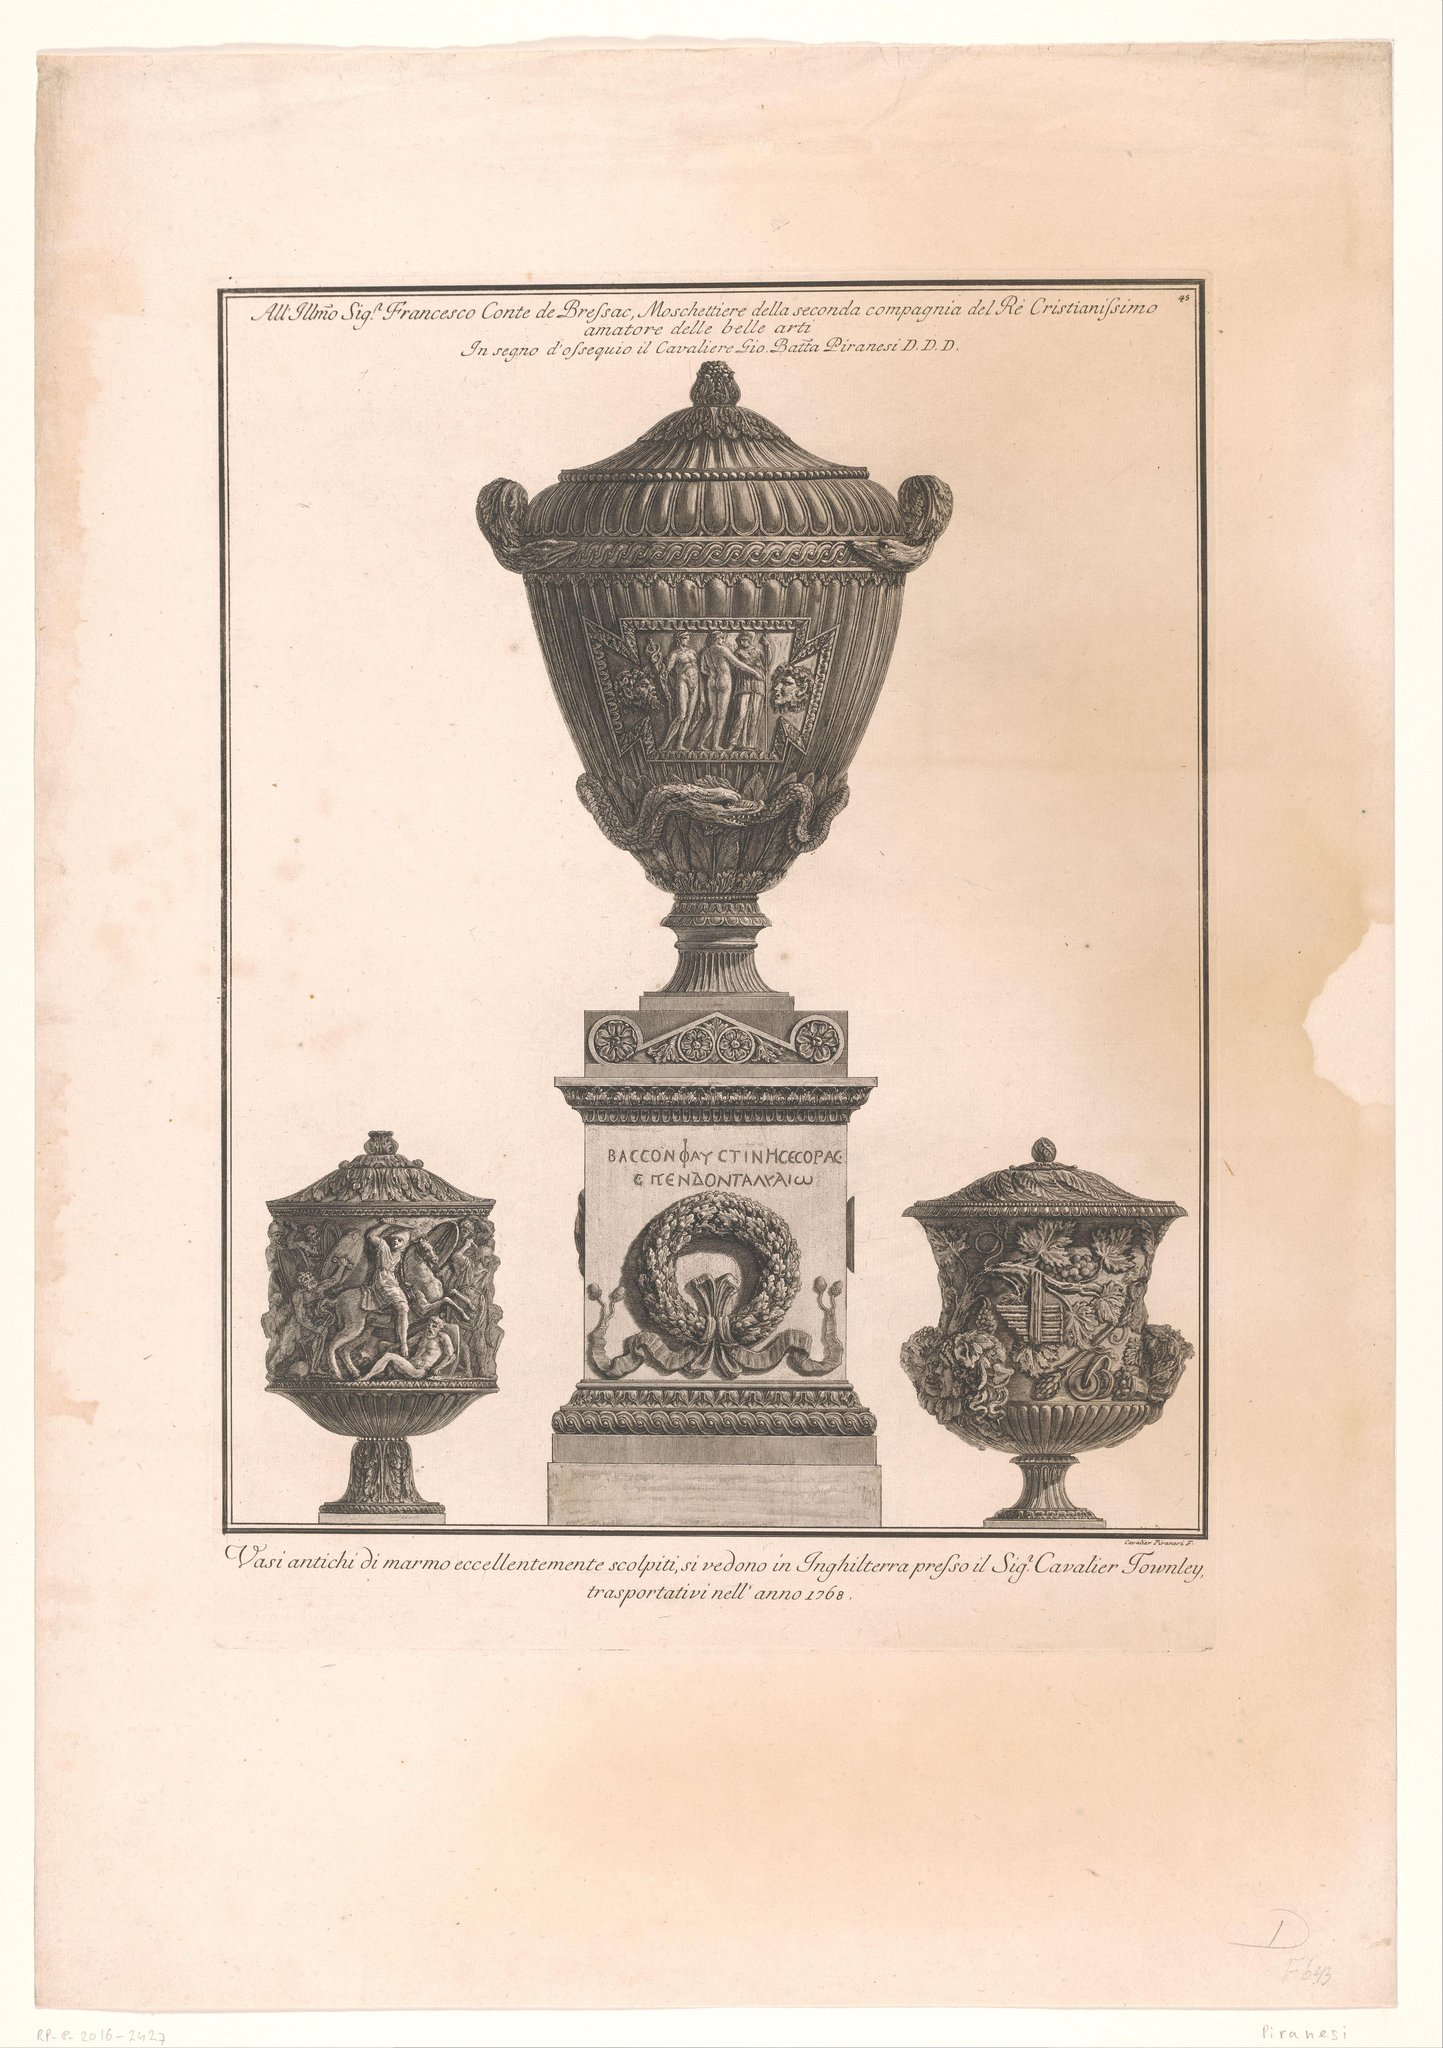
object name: print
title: Drie antieke vazen waarvan een op voetstuk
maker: giovanni battista piranesi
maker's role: designer, draughtsman, print maker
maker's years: 1720-1778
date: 1778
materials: paper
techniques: etching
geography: rome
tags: vase ~ ornament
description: De 'Vasi'-reeks telt 110 prenten, verspreid over twee volumes met elk een eigen titelprent. Piranesi werd voor deze reeks geholpen door verschillende assistenten uit zijn werkplaats, waaronder zijn zoon Francesco die ook nog eens 8 platen toevoegde aan de reeks in 1779-1780.